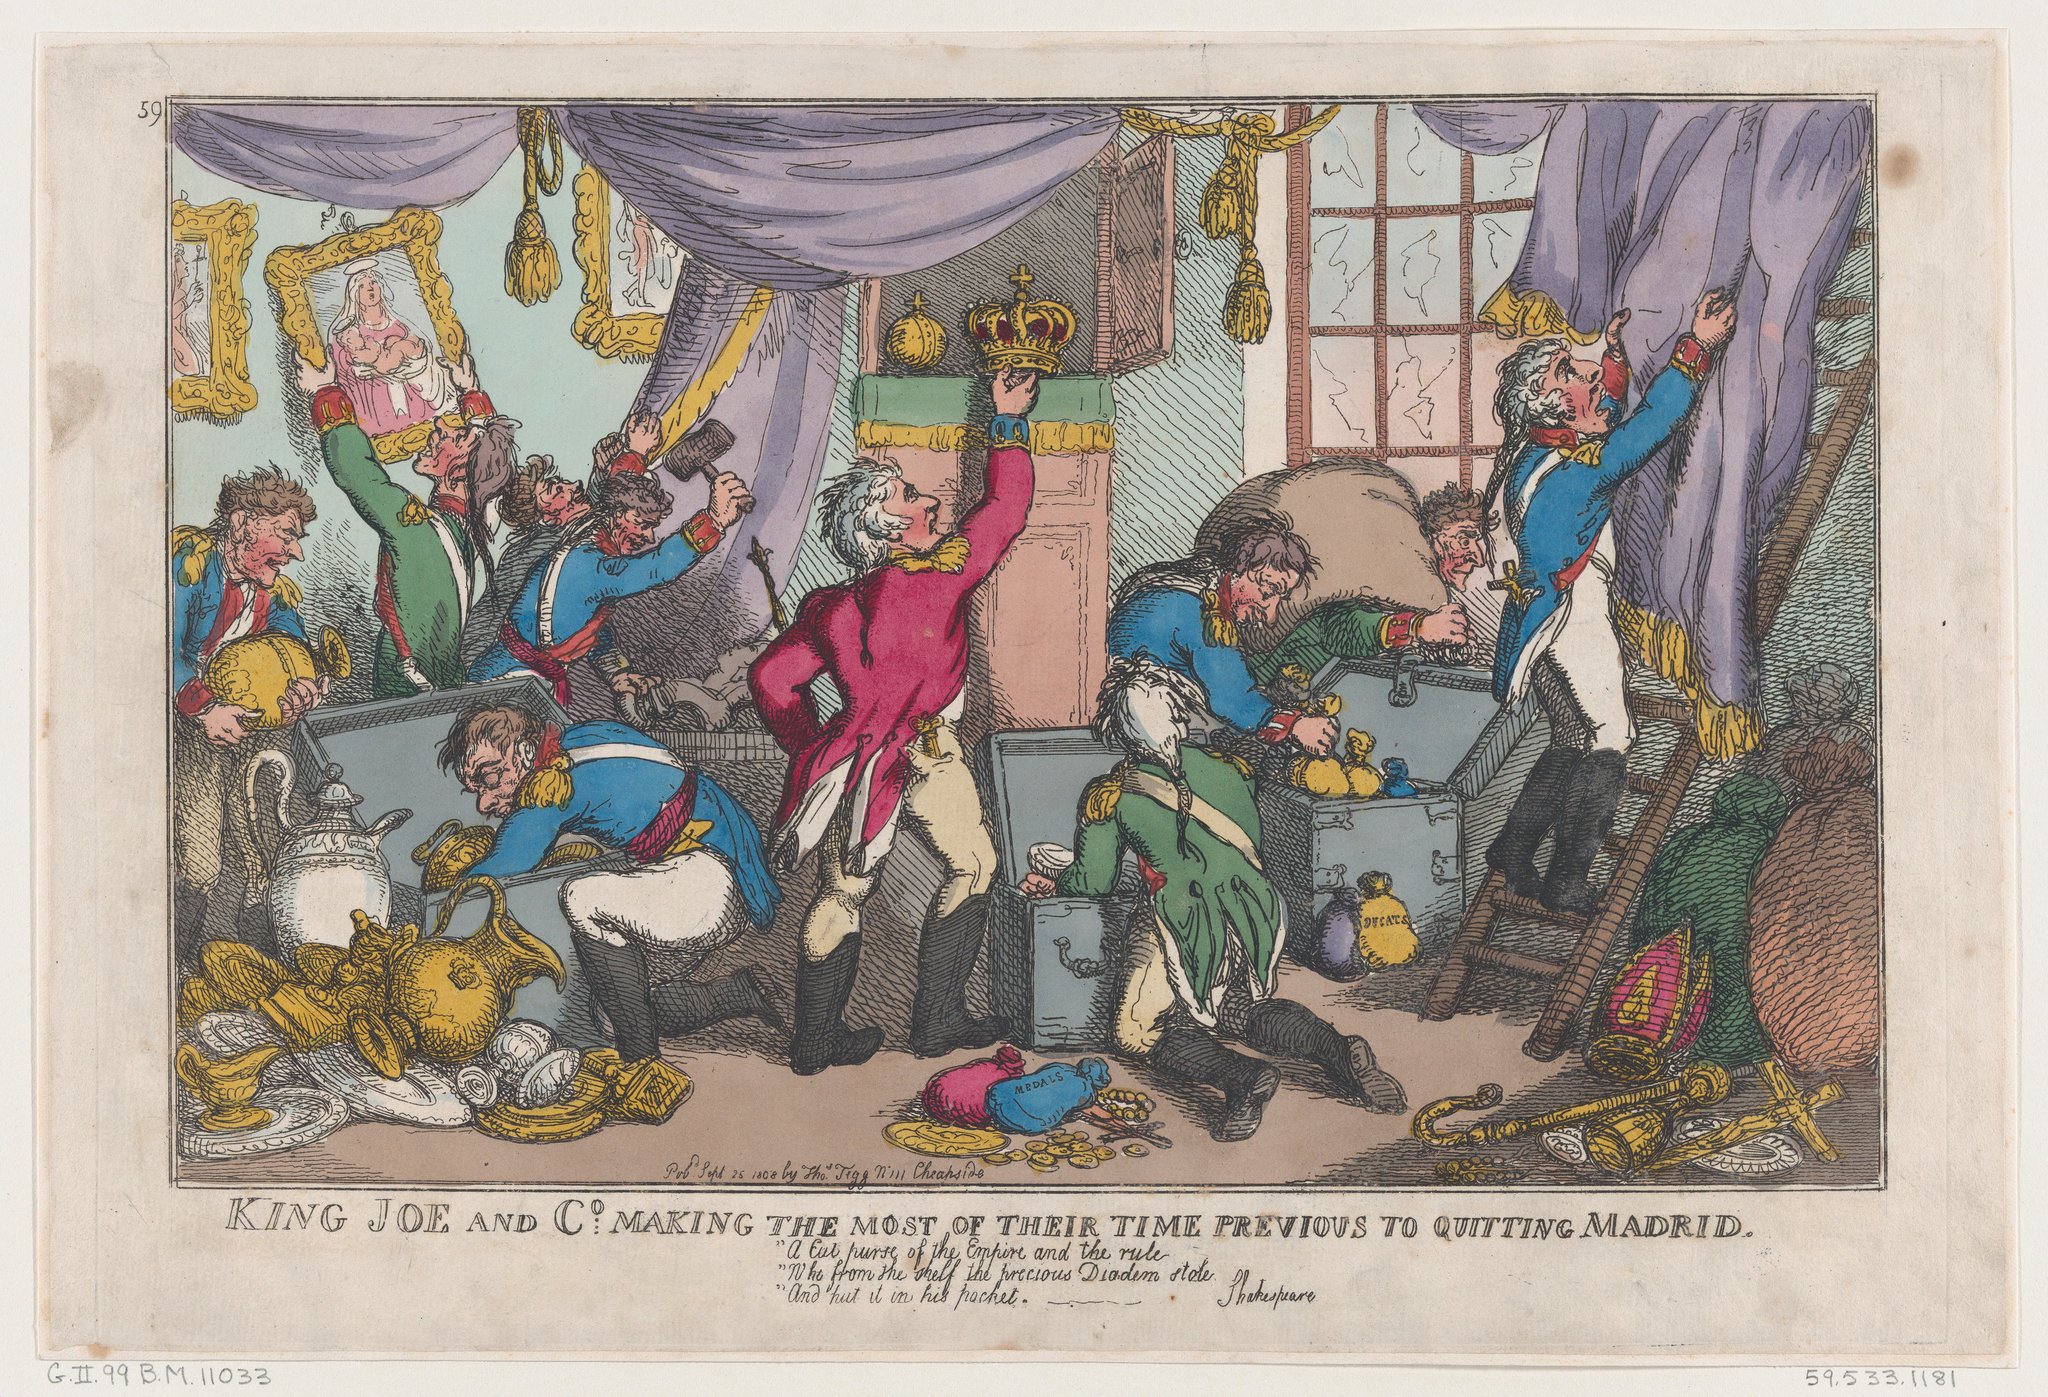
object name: print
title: King Joe and Co. Making the Most Of Their Time Previous To Quitting Madrid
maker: thomas rowlandson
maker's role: artist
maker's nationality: british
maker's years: 1757-1827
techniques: etching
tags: satire,men,politics